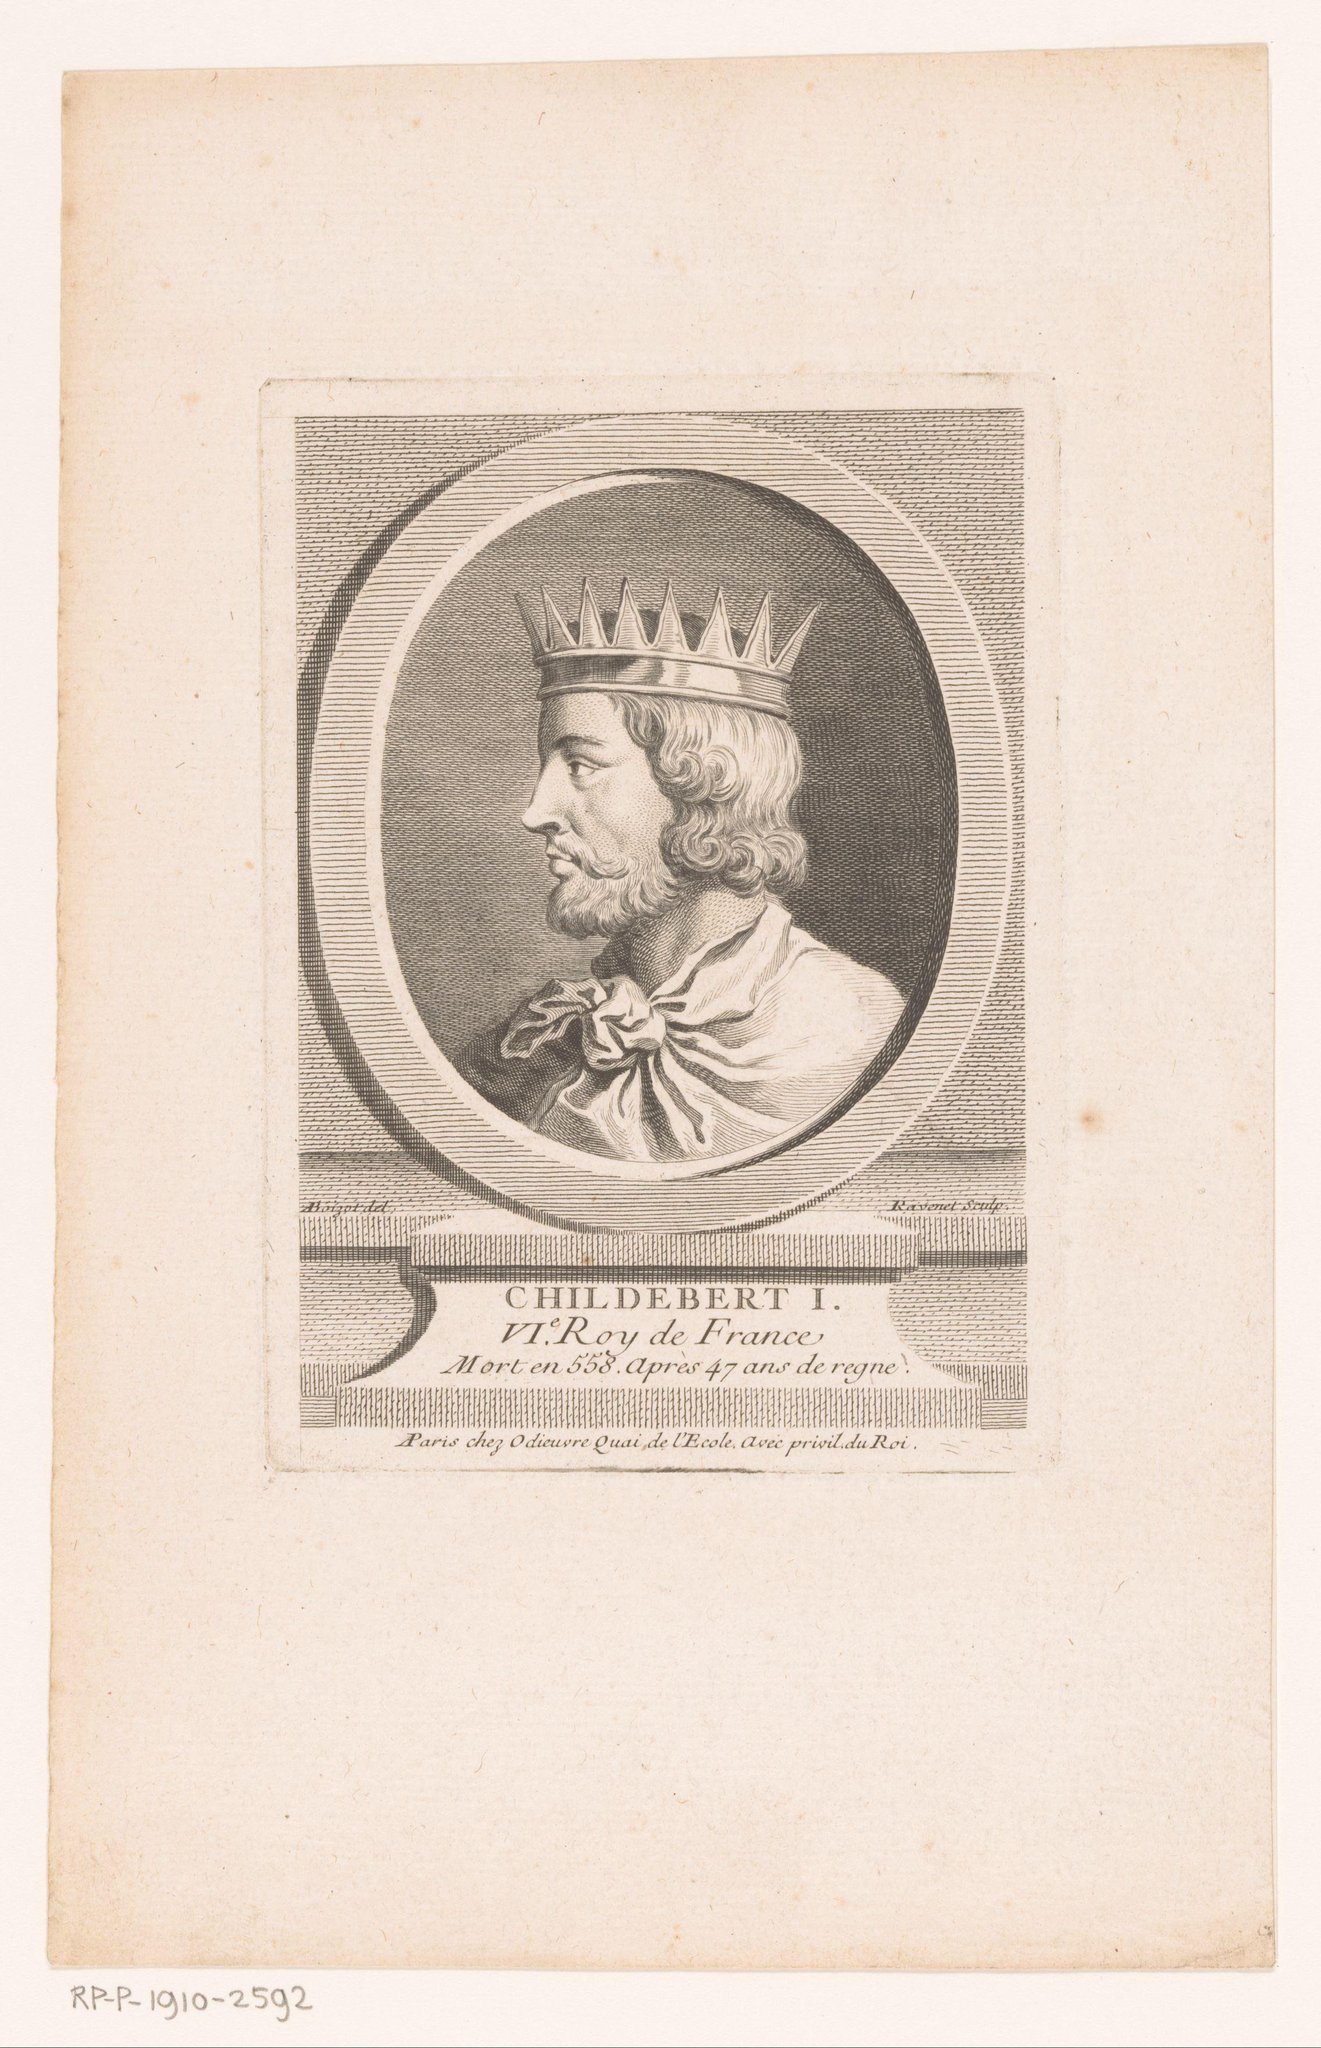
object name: print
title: Portret van Childebert I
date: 1716-1756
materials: paper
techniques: engraving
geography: france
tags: historical persons, king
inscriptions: collector's mark: Lugt 2228